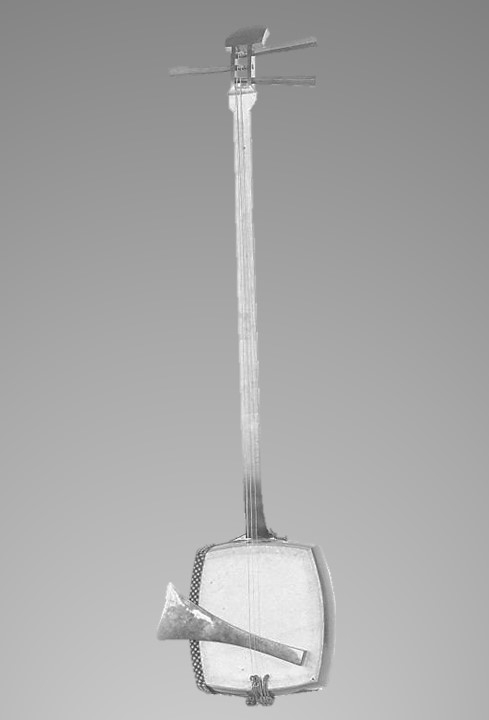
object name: shamisen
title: Shamisen (三味線)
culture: japanese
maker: shigemoto, isohachi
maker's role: maker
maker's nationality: japanese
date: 1875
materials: textile, skin, wood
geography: japan